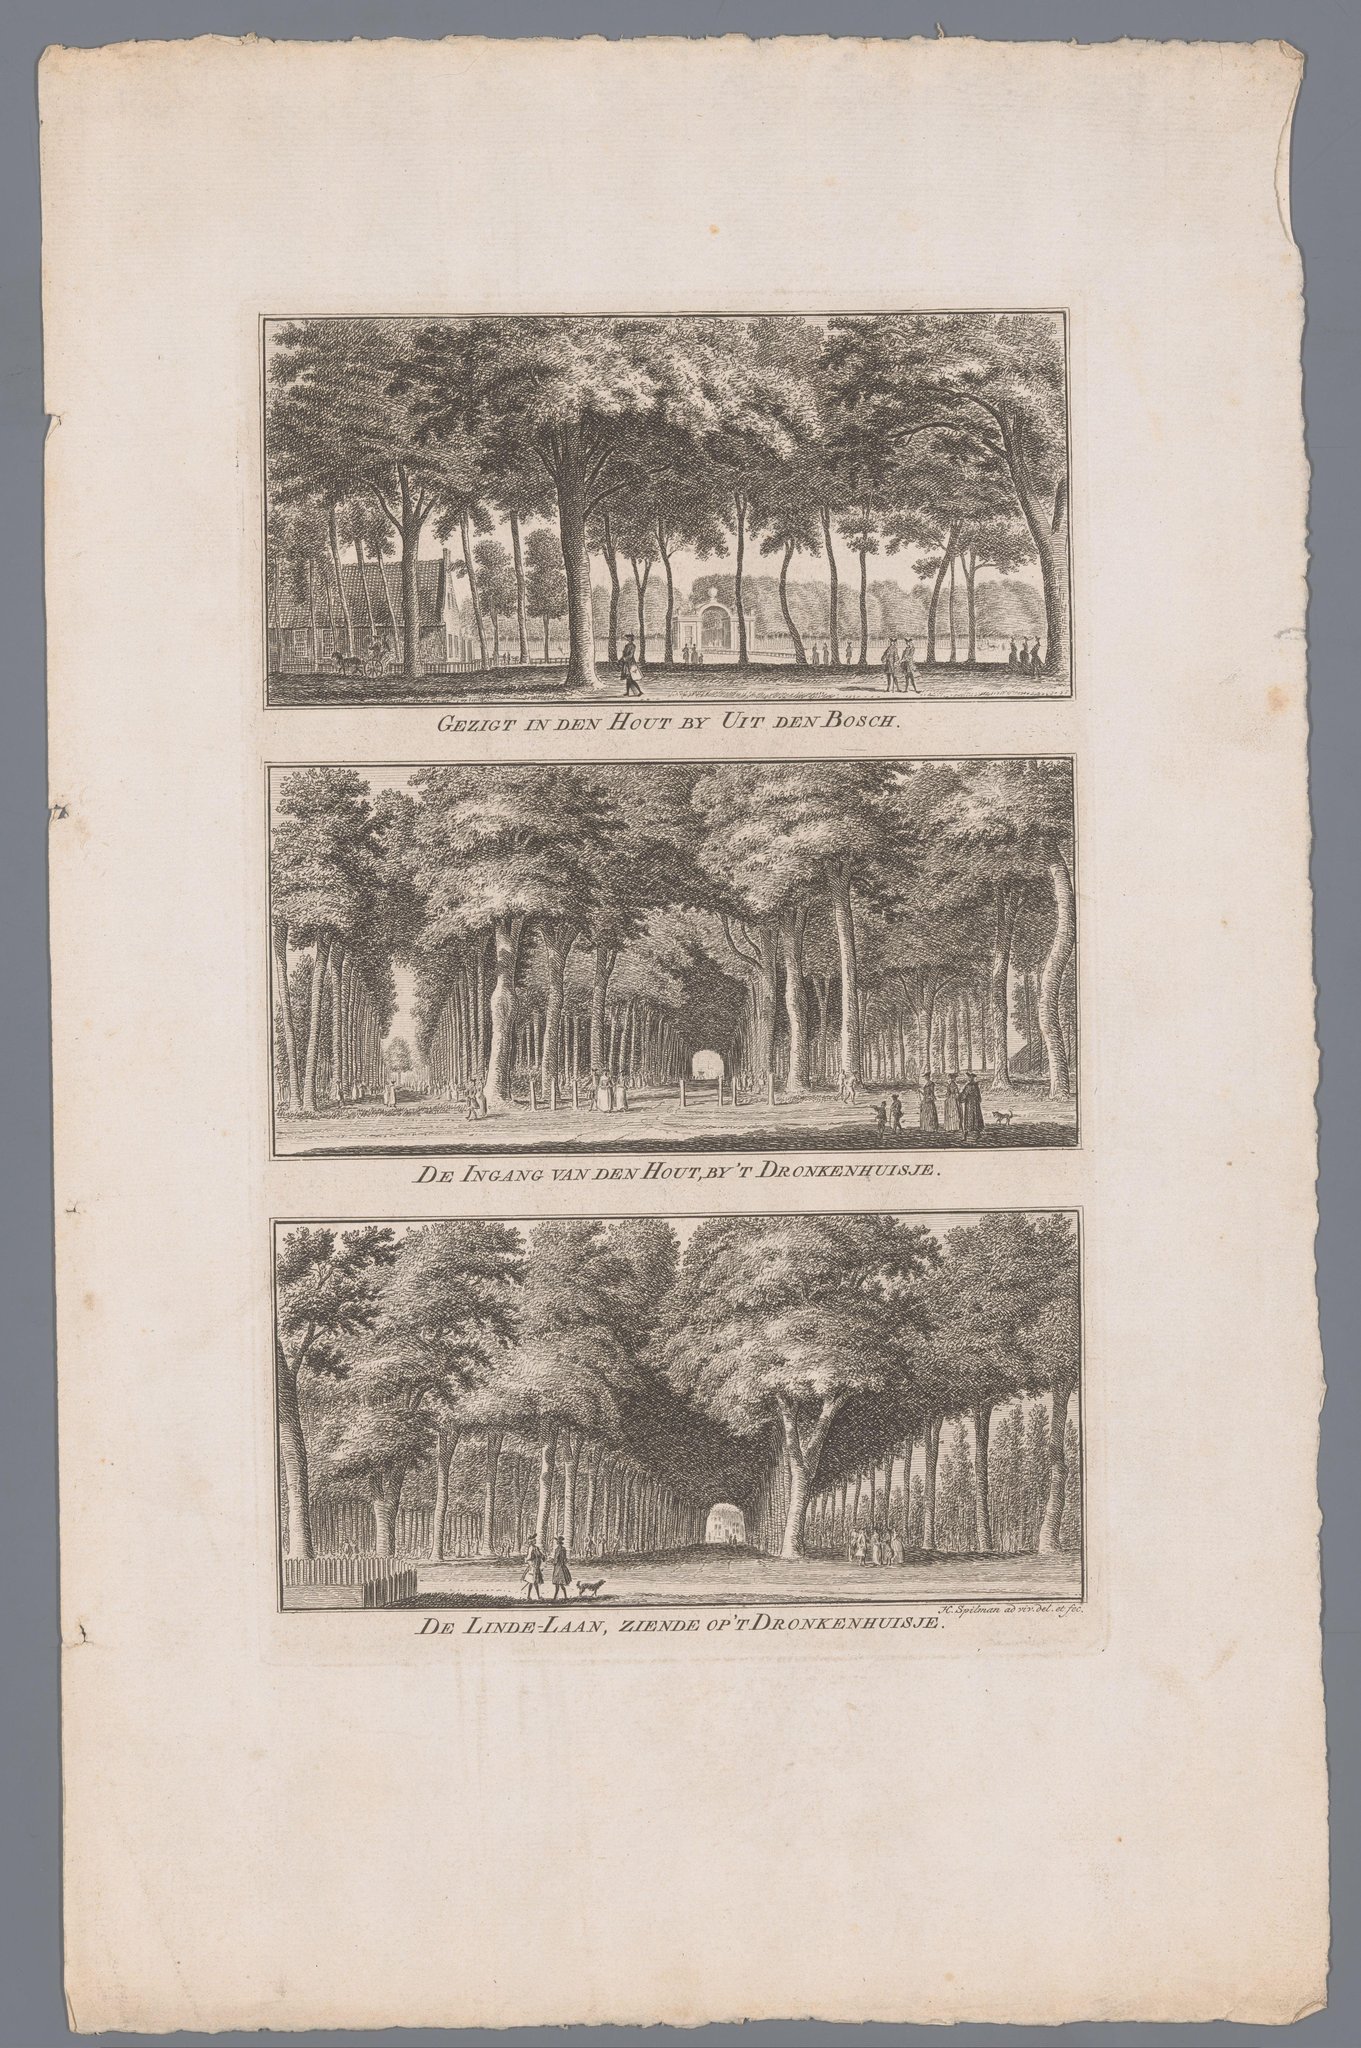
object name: print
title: Gezichten in de vermakelijke landsdouwen van Haarlem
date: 1763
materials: paper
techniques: etching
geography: haarlem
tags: trees, open-air recreation, lane, alley, haarlem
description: Prent uit: Verzaameling van zes- en zestig aangenaame gezichten in de vermakelyke landsdouwen van Haarlem. Haarlem: Jan Bosch, 1763.